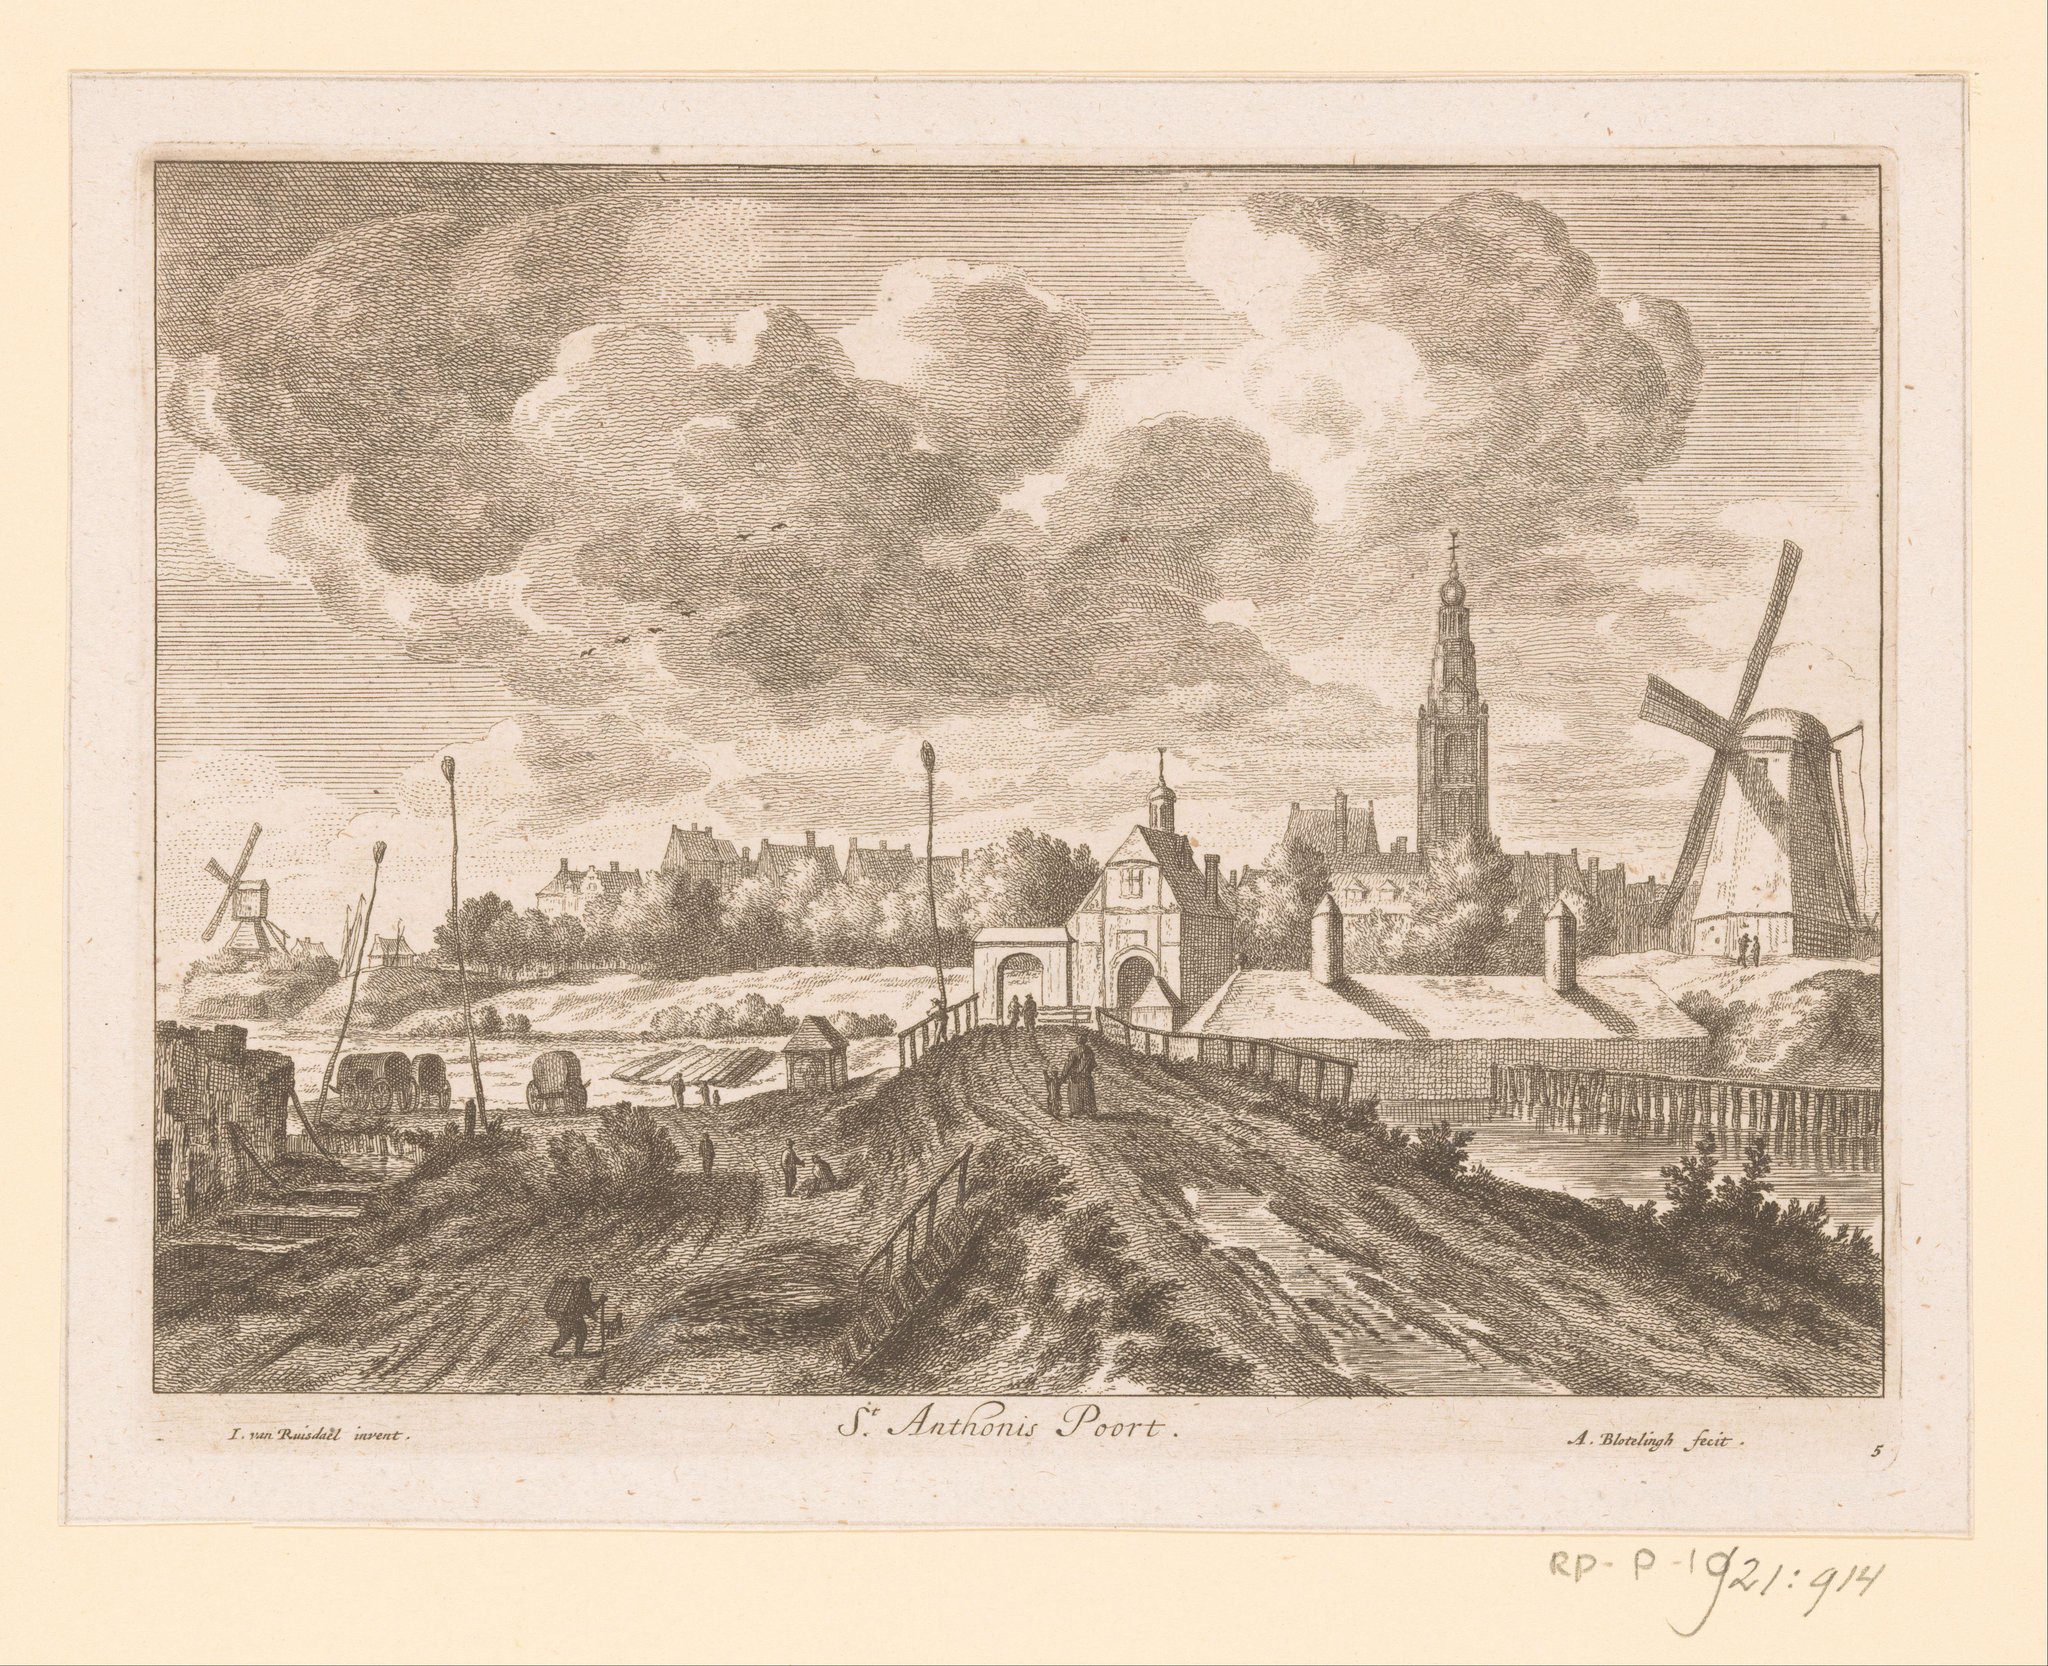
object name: print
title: St. Anthonis poort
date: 1655-1690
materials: paper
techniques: engraving, etching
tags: windmill in landscape, city-gate, parts of church exterior and annexes: tower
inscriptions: collector's mark: Lugt 2233